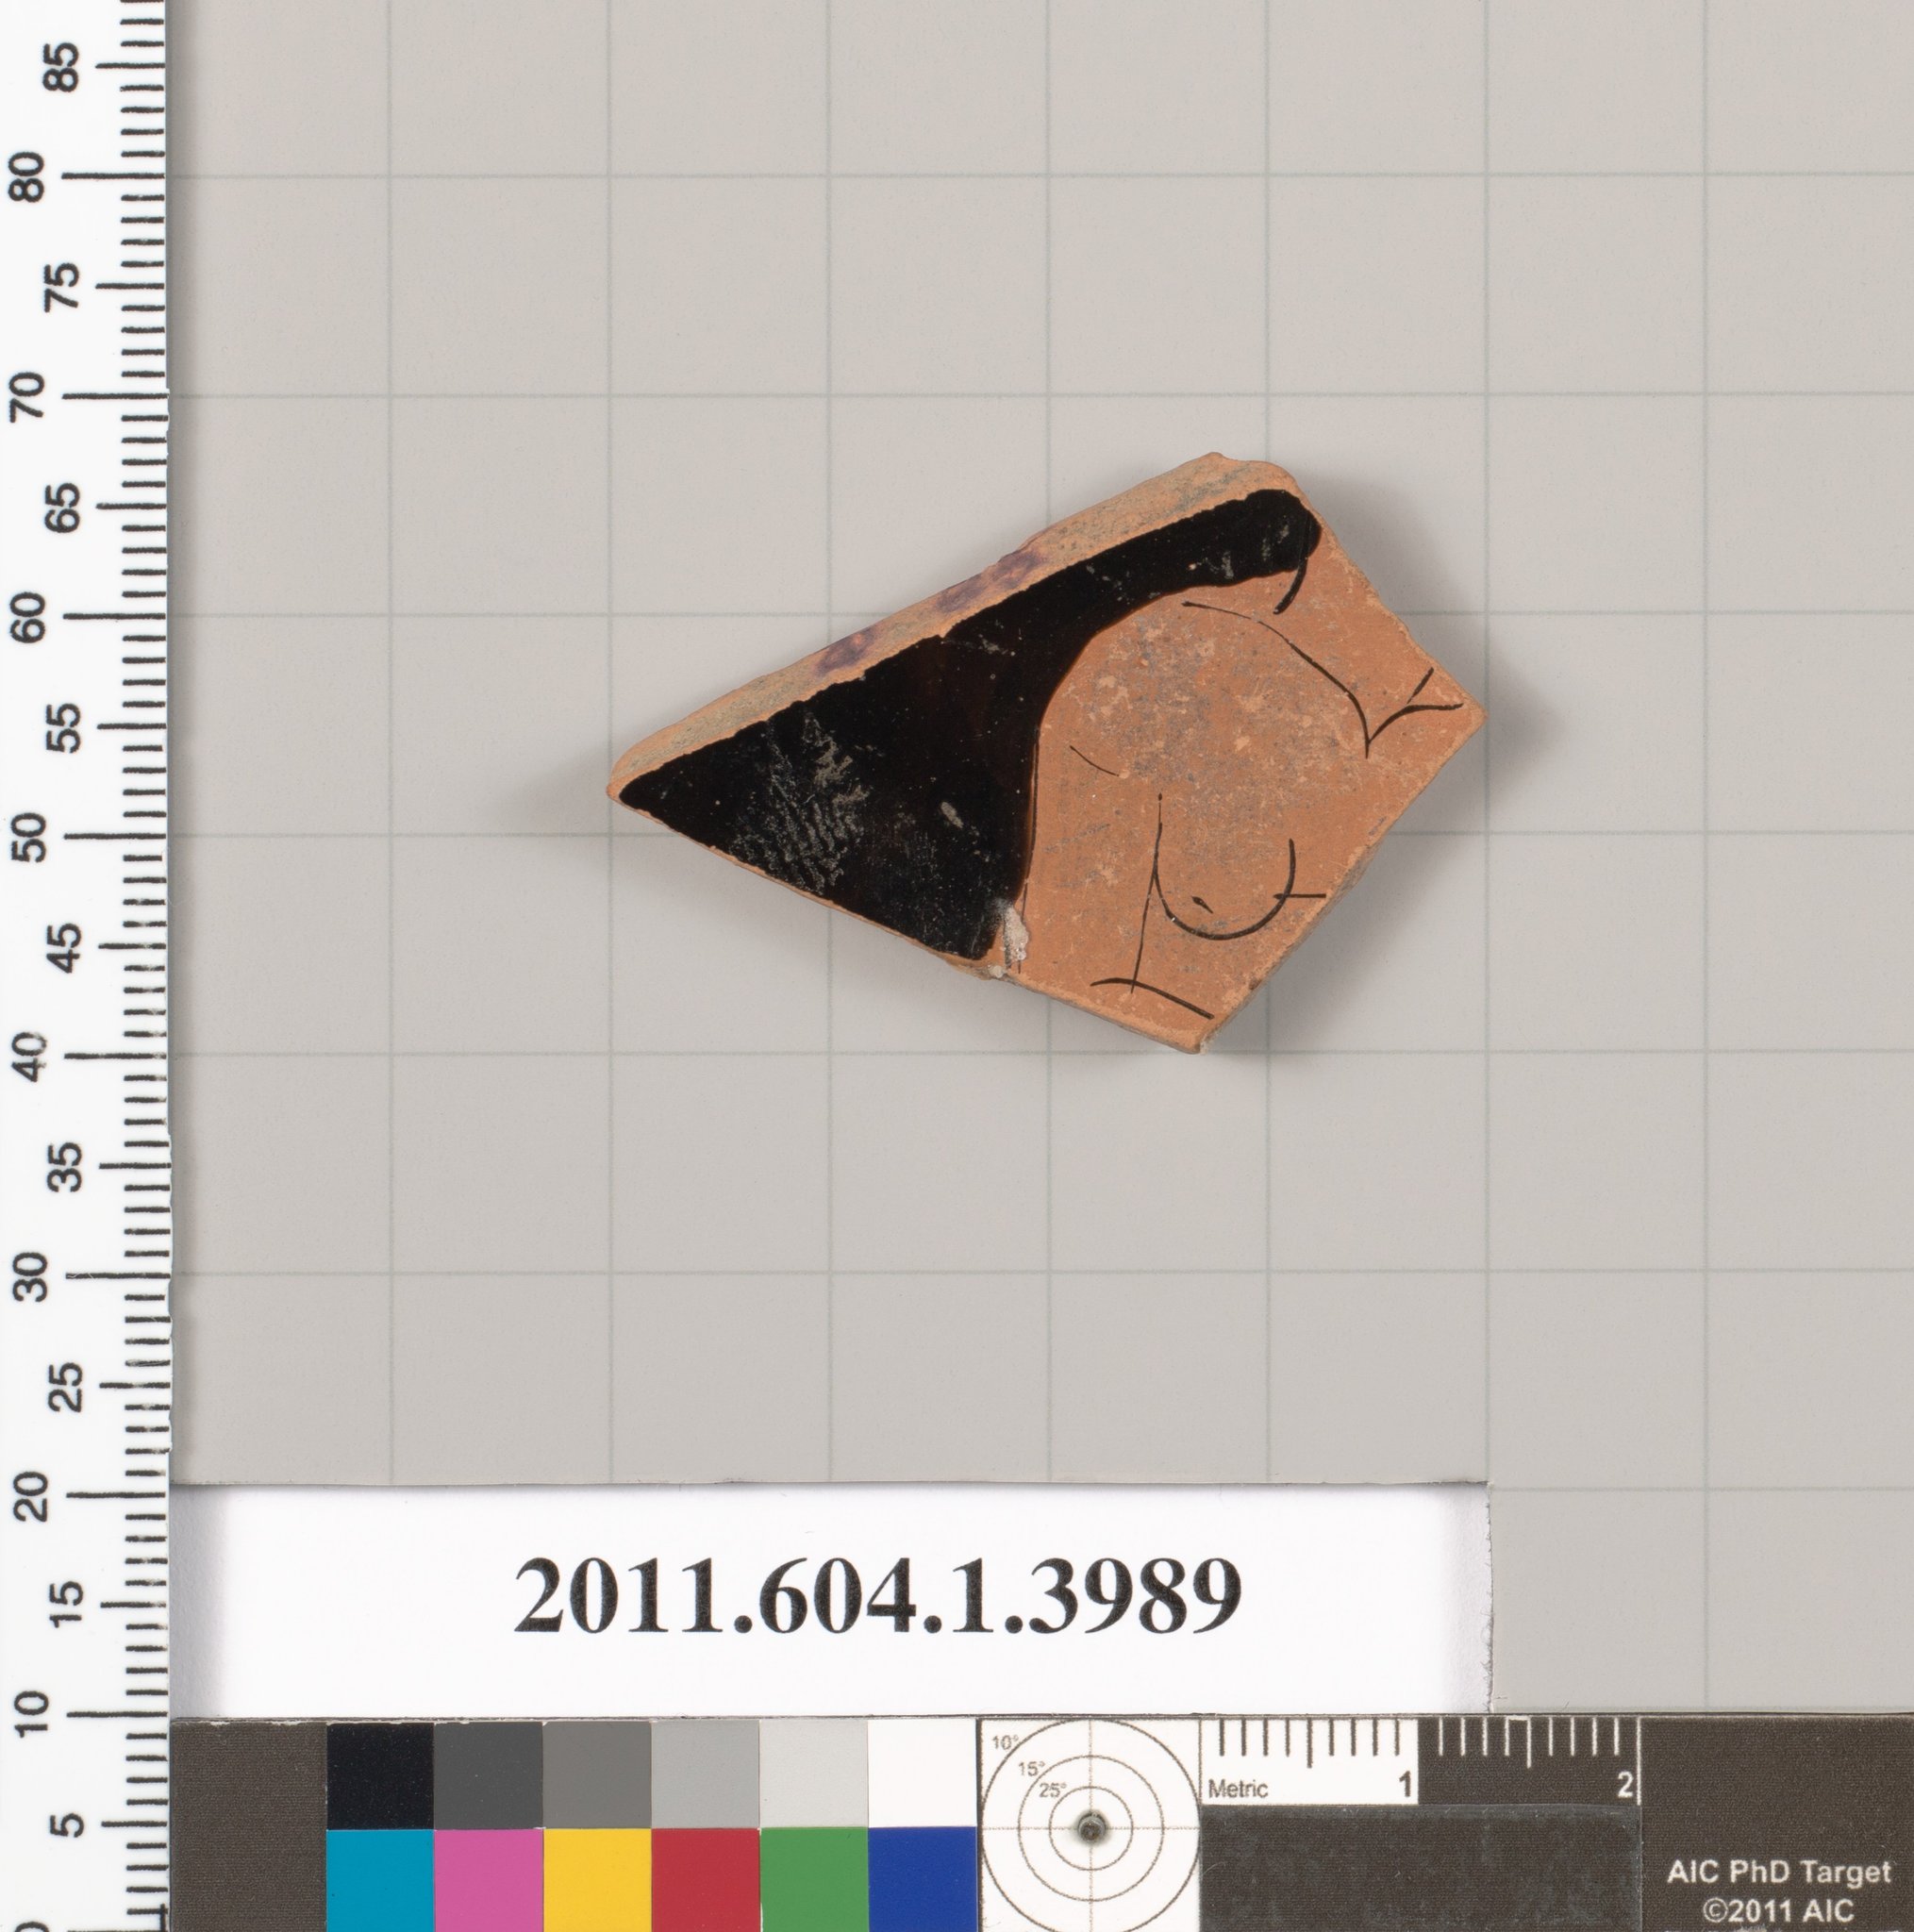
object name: kylix fragment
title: Terracotta fragment of a kylix (drinking cup)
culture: greek, attic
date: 460-440 BCE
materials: terracotta